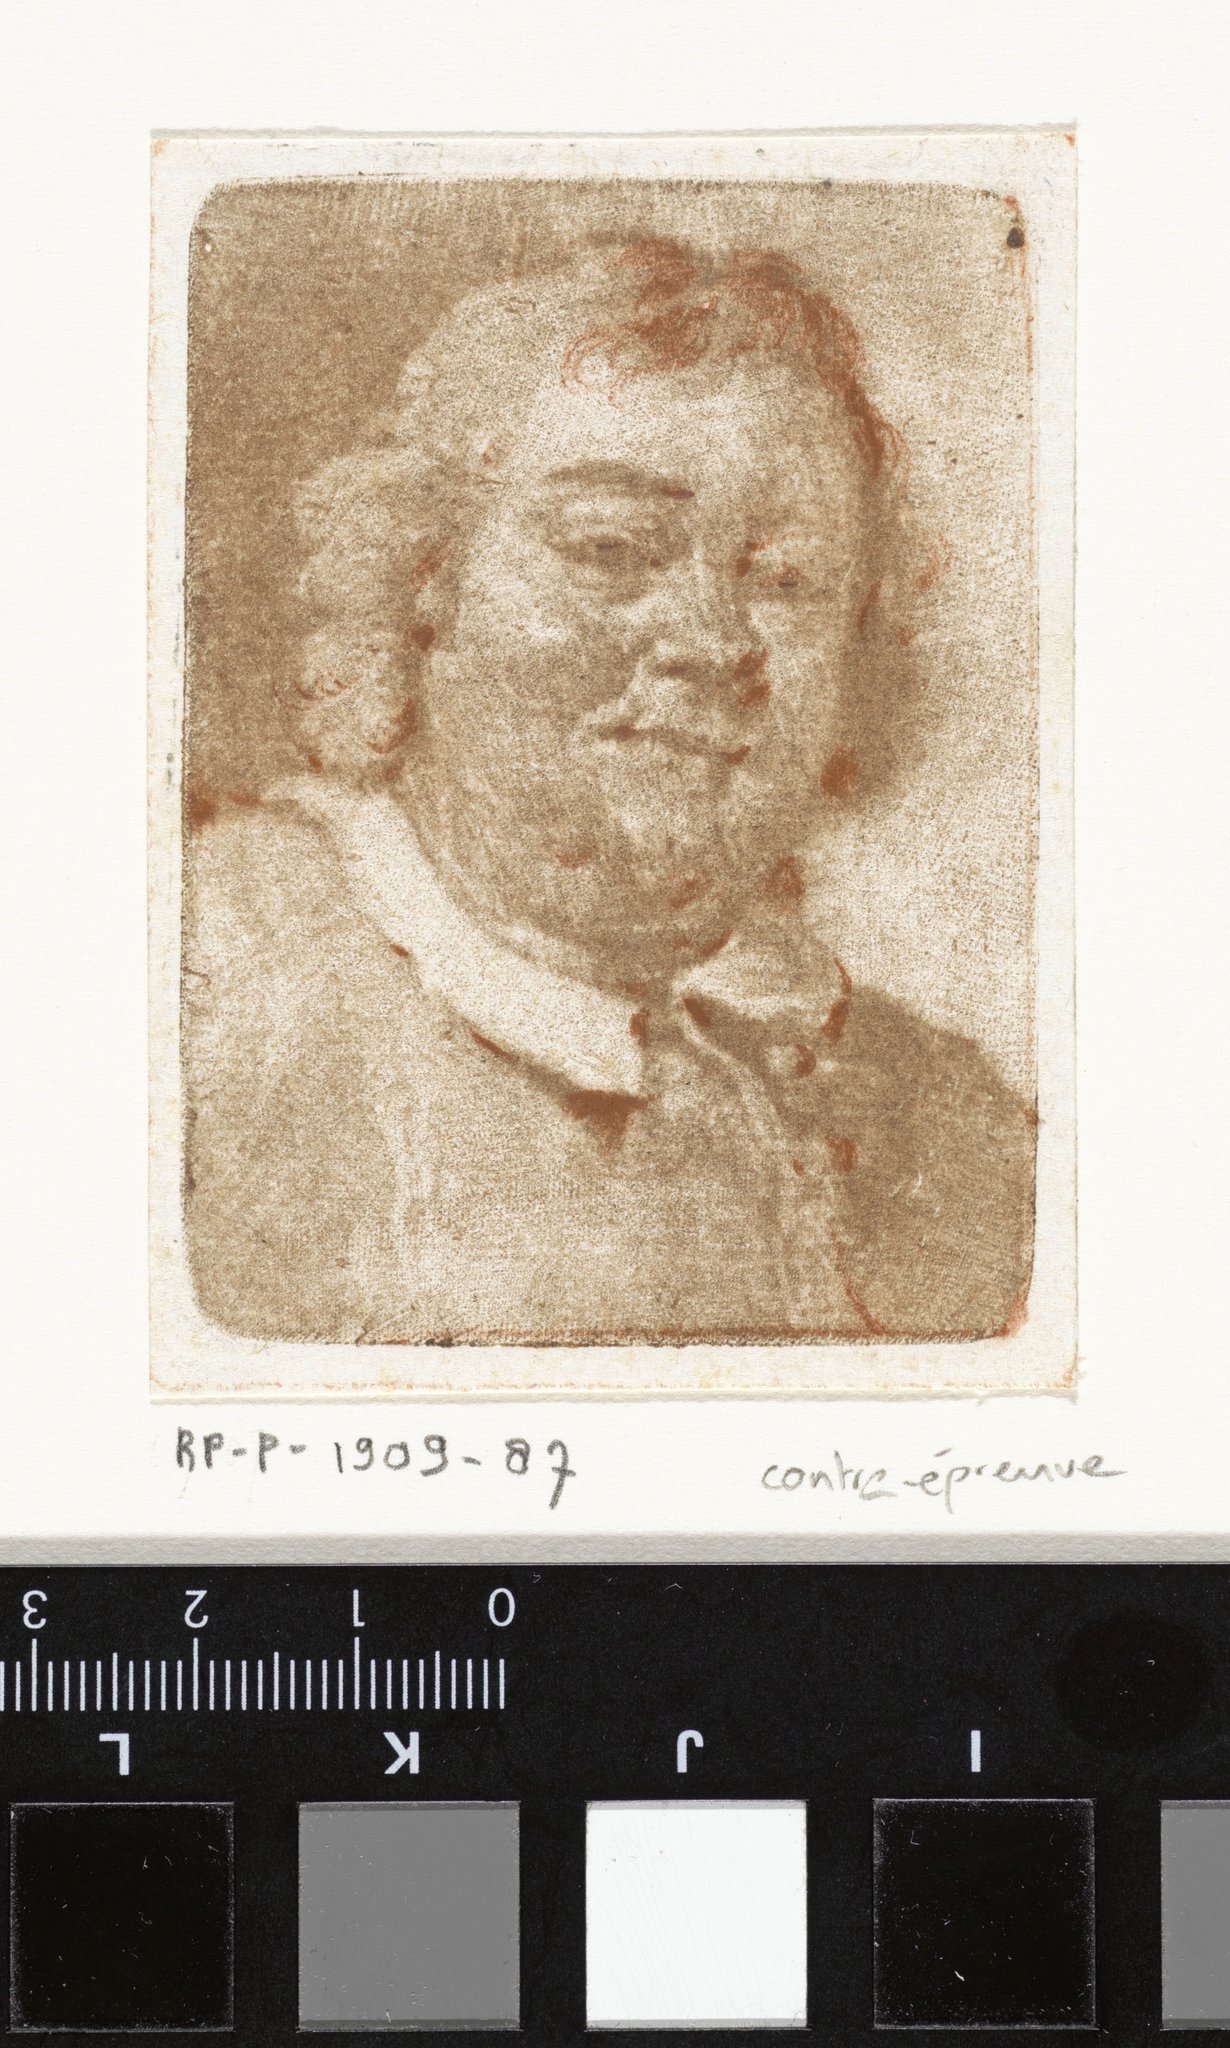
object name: print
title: Buste van een man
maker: aert schouman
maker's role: draughtsman, painter, print maker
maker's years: 1710-1792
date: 1720-1792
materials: paper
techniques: brush, printmaking, pen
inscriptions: collector's mark: Lugt 2228